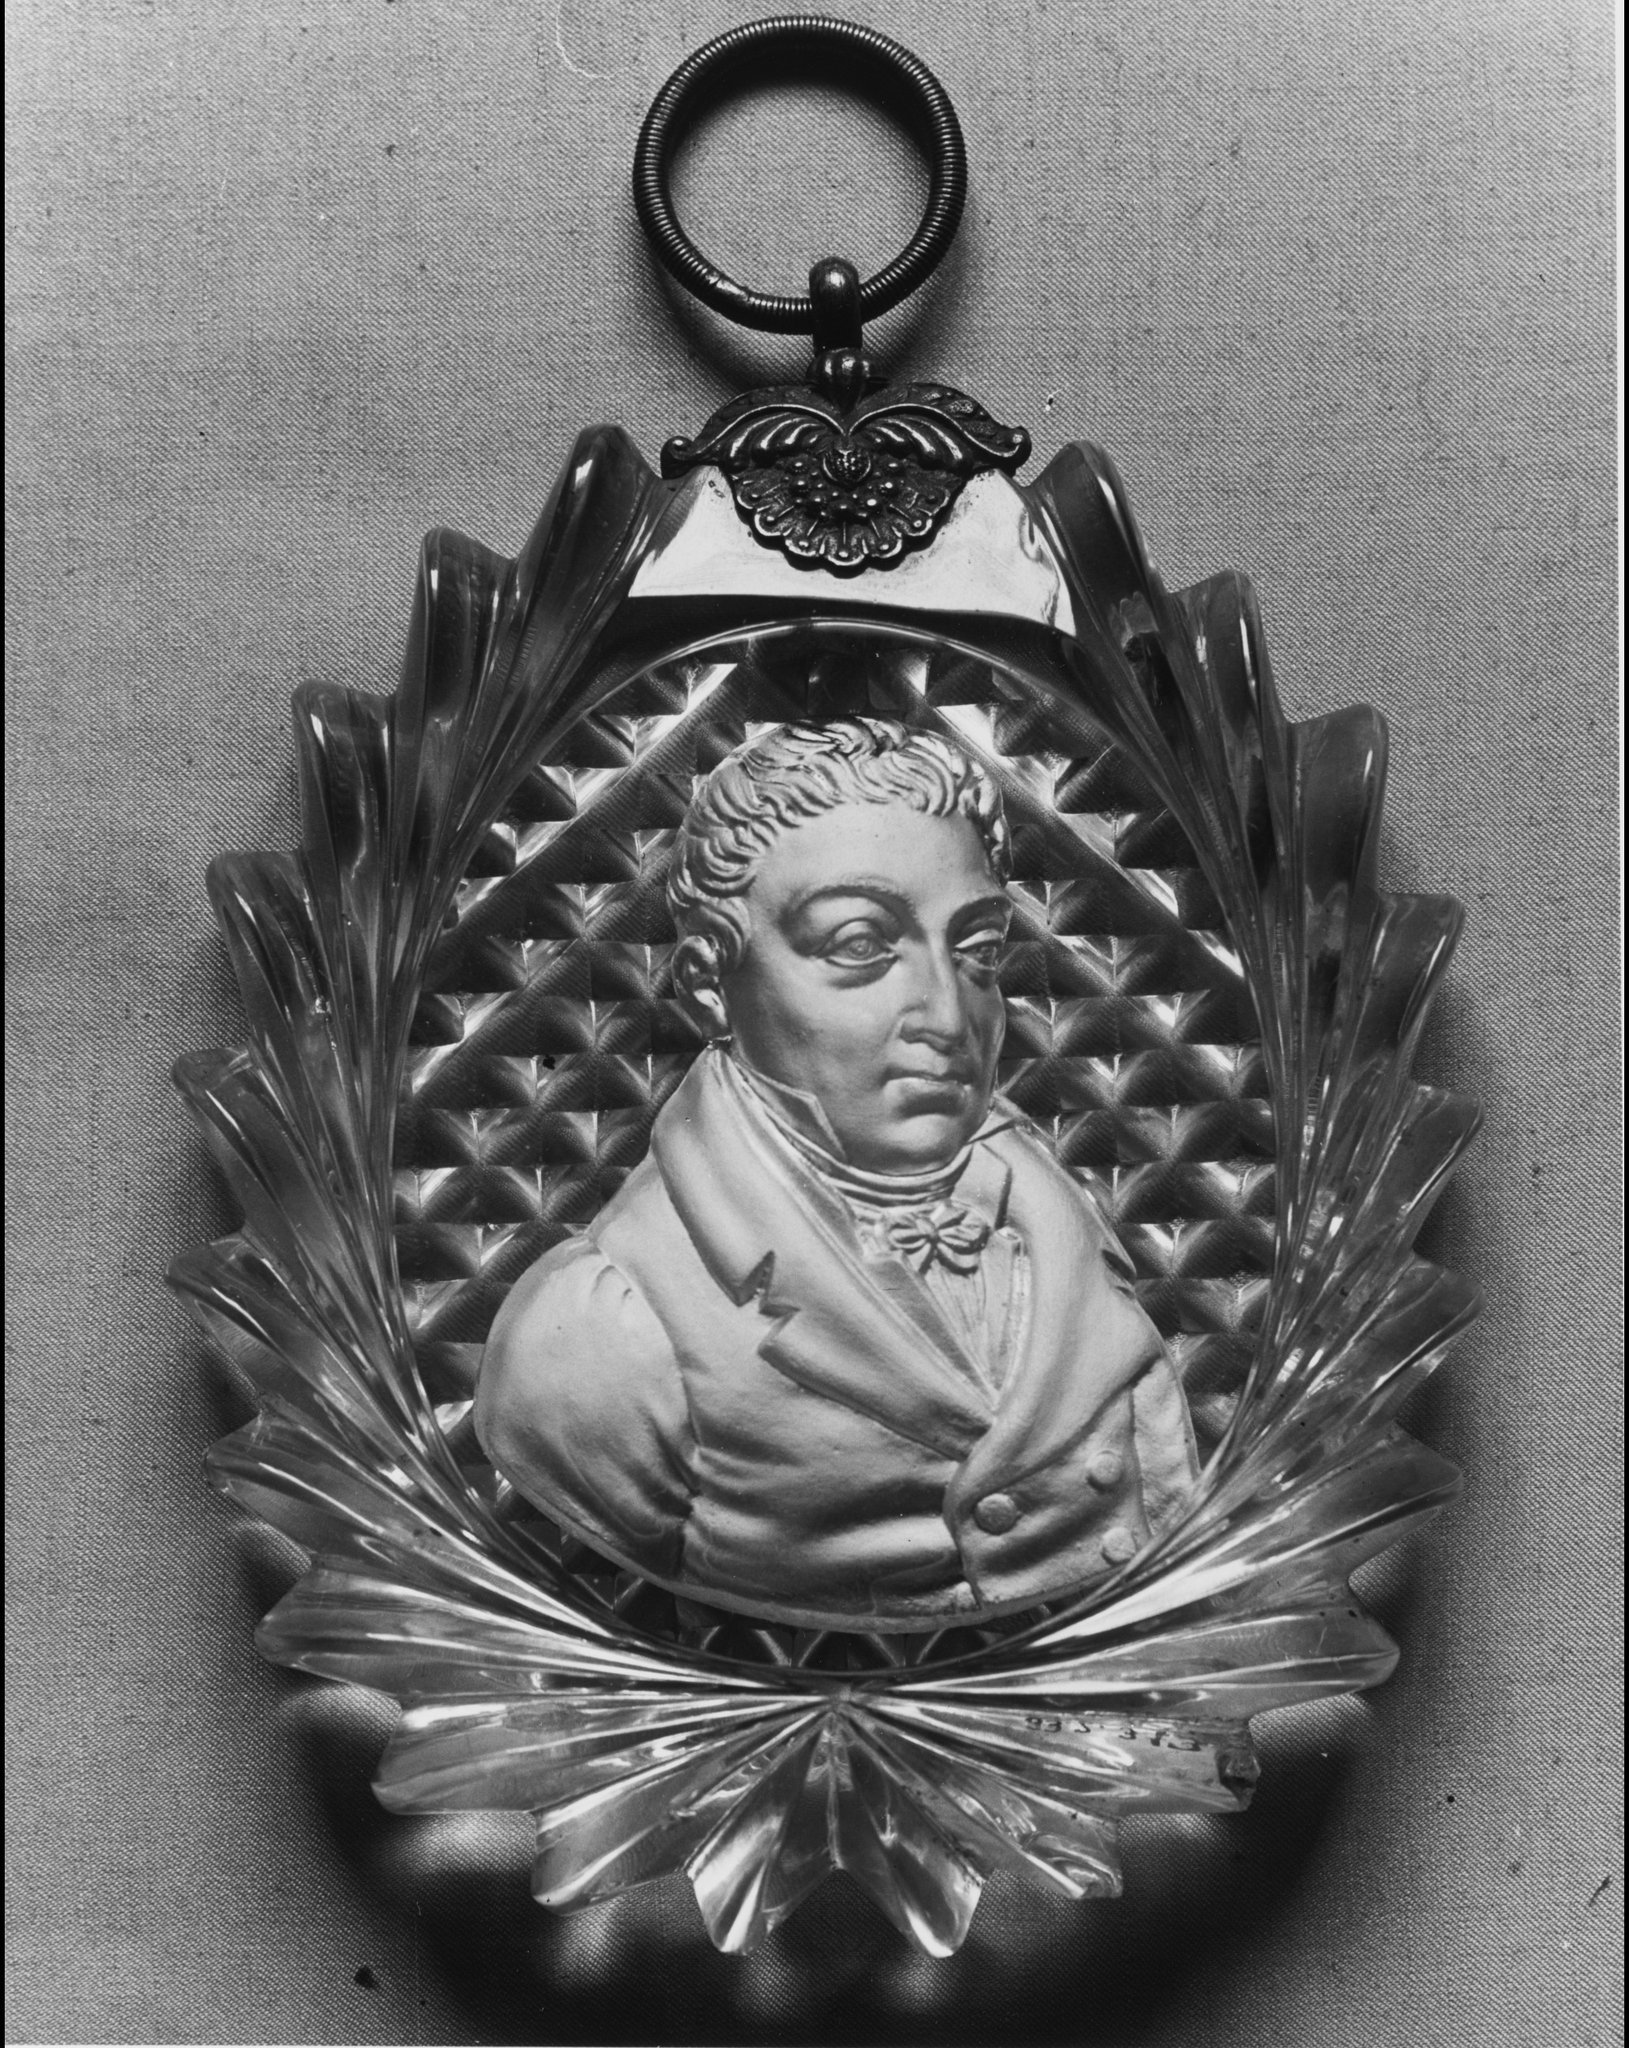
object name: medallion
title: Medallion of the Marquis de Lafayette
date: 1800-1883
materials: glass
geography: france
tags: men,portraits,marquis de lafayette